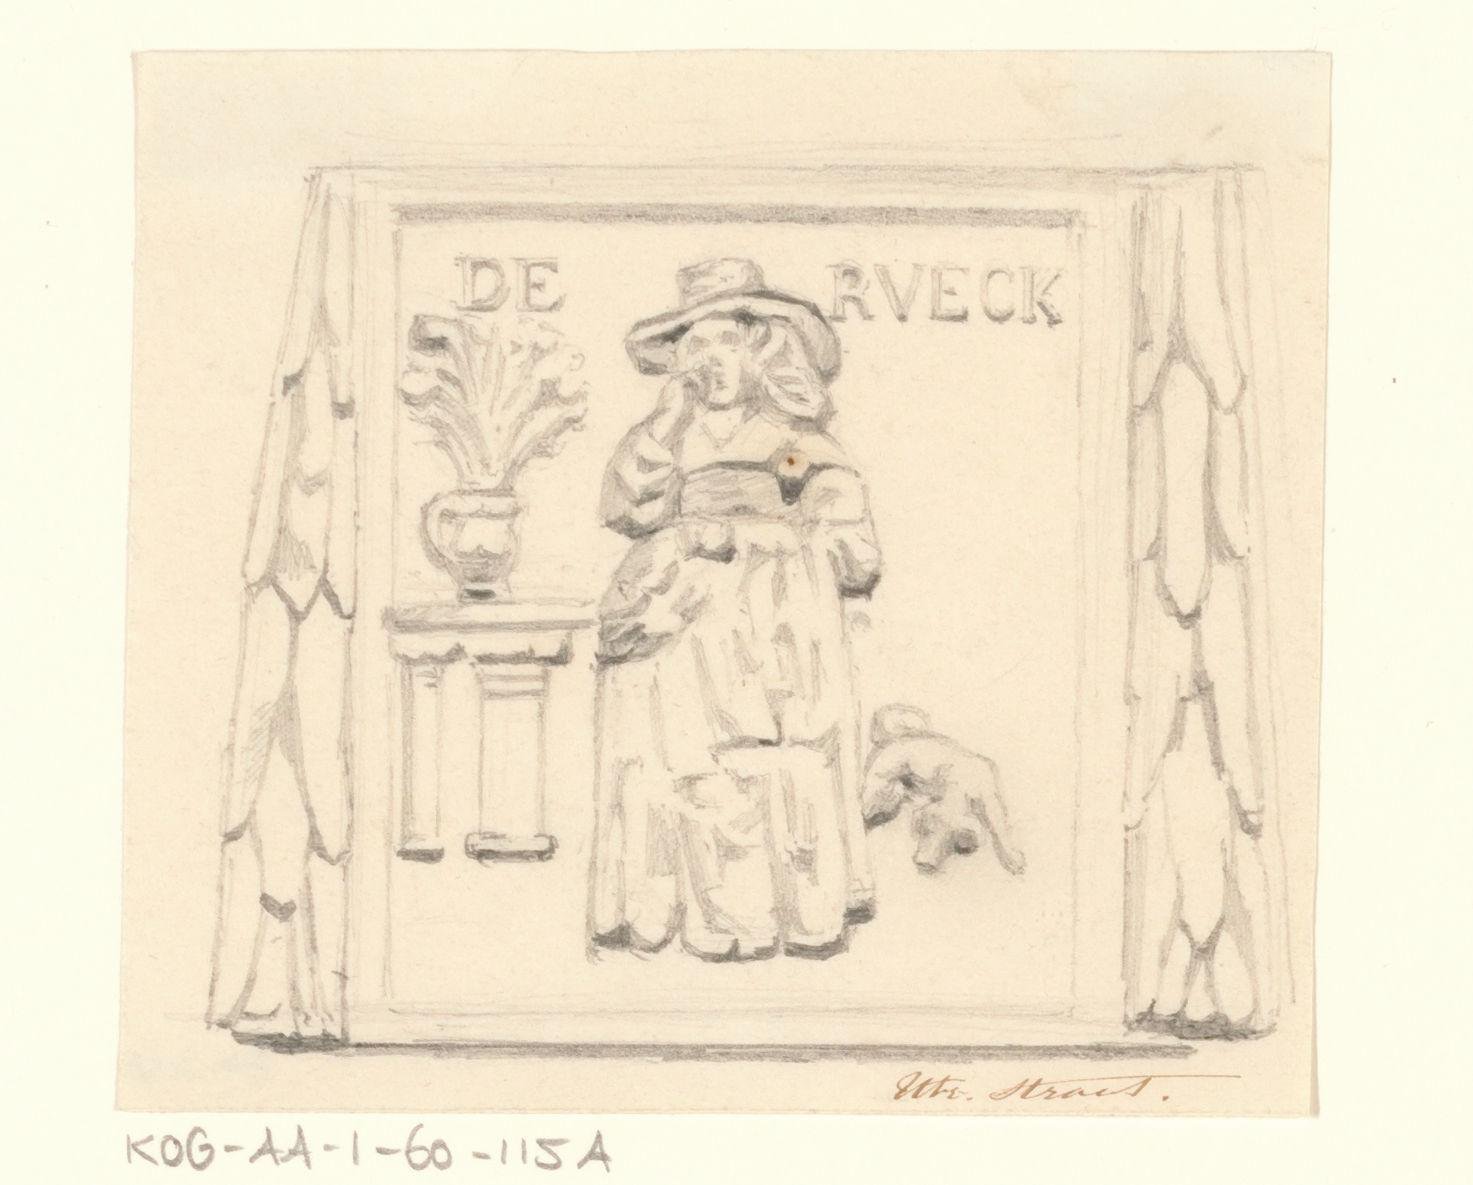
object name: drawing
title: Gevelstenen met verbeeldingen van de vijf zintuigen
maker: Anonymous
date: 1800-1899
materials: paper, pencil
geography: amsterdam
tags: stone tablet in façade, smell, smelling (one of the five senses)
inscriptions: inscription: ‘Utr. straat.’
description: Onderwerpsrubriek binnen de Atlas Amsterdam: Beeldhouwkunst - Gevelstenen.